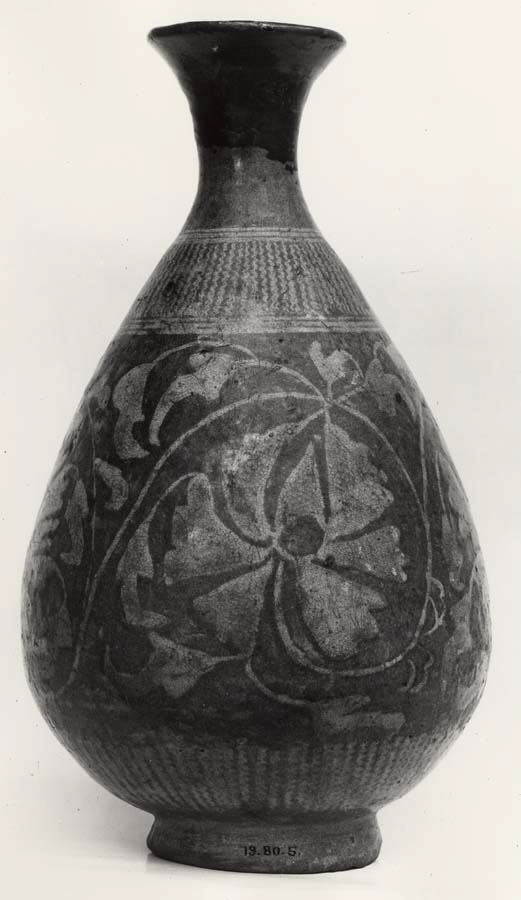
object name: vase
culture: korean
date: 1301-1500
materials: clay